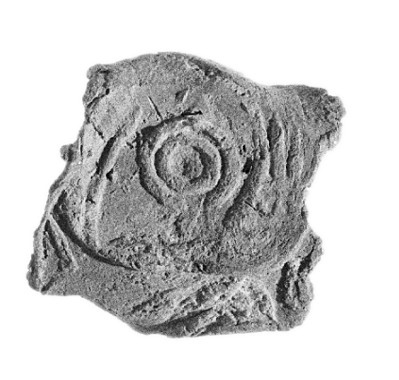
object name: sealing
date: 1981-1640 BCE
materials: mud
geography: egypt